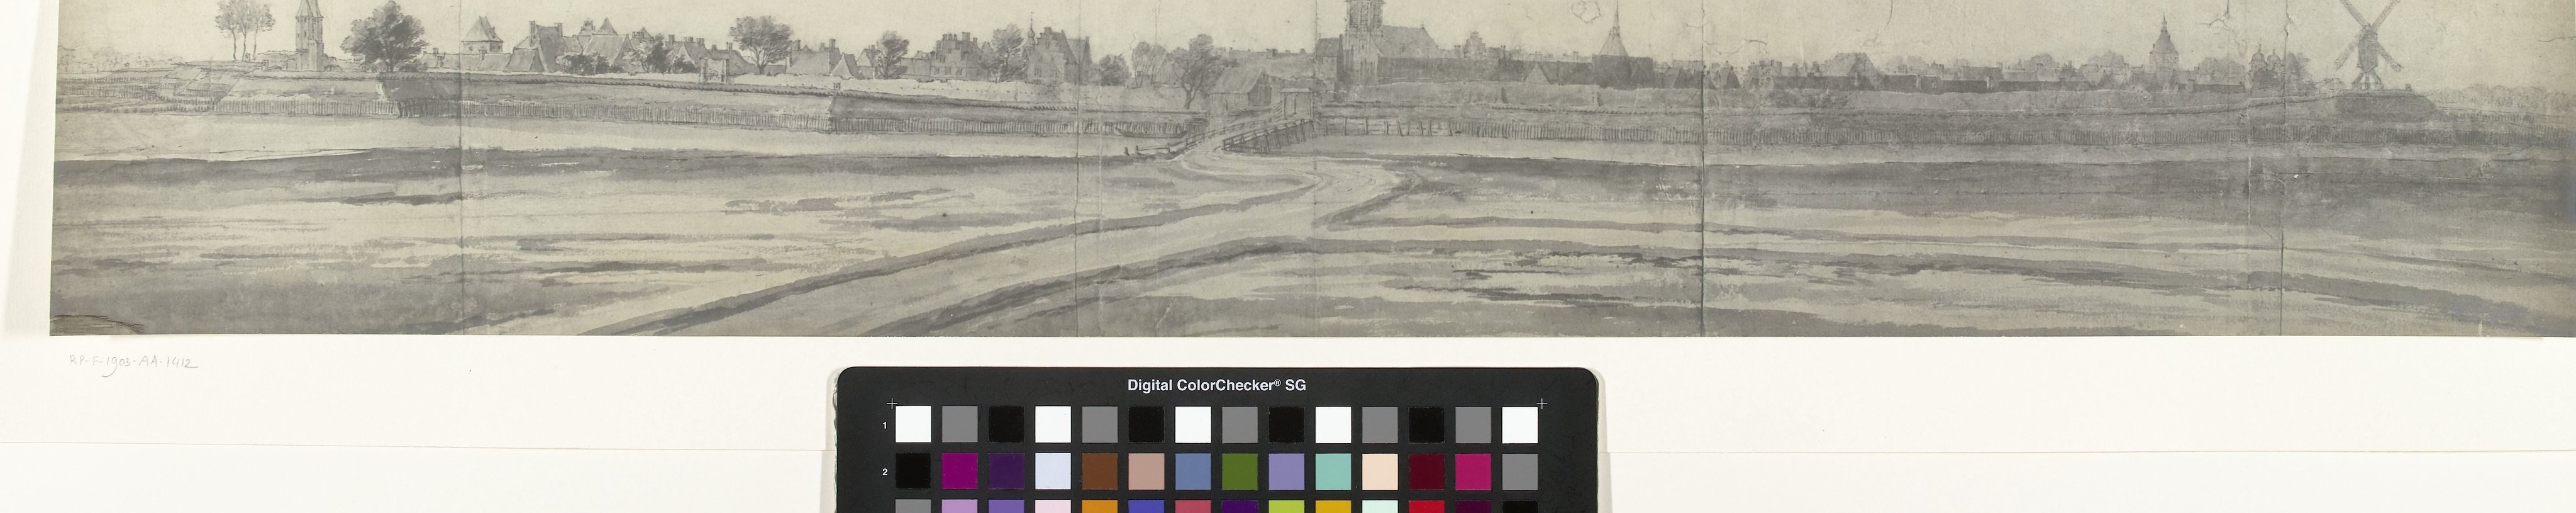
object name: photograph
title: Gezicht op Doetinchem, 1672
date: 1900-1903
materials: paper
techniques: gelatin silver print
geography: france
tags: lodewijk xiv (koning van frankrijk), prospect of city, town panorama, silhouette of city, rampjaar (disaster year)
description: Niet in Frederik Muller; door het RPK toegevoegd nummer. Onderdeel van een groep van ca. 50 foto's van tekeningen van de Franse inval in de Nederlanden in 1672 door Adam Frans van der Meulen, bewaard in de Manufacture Nationale des Gobelins te Parijs.